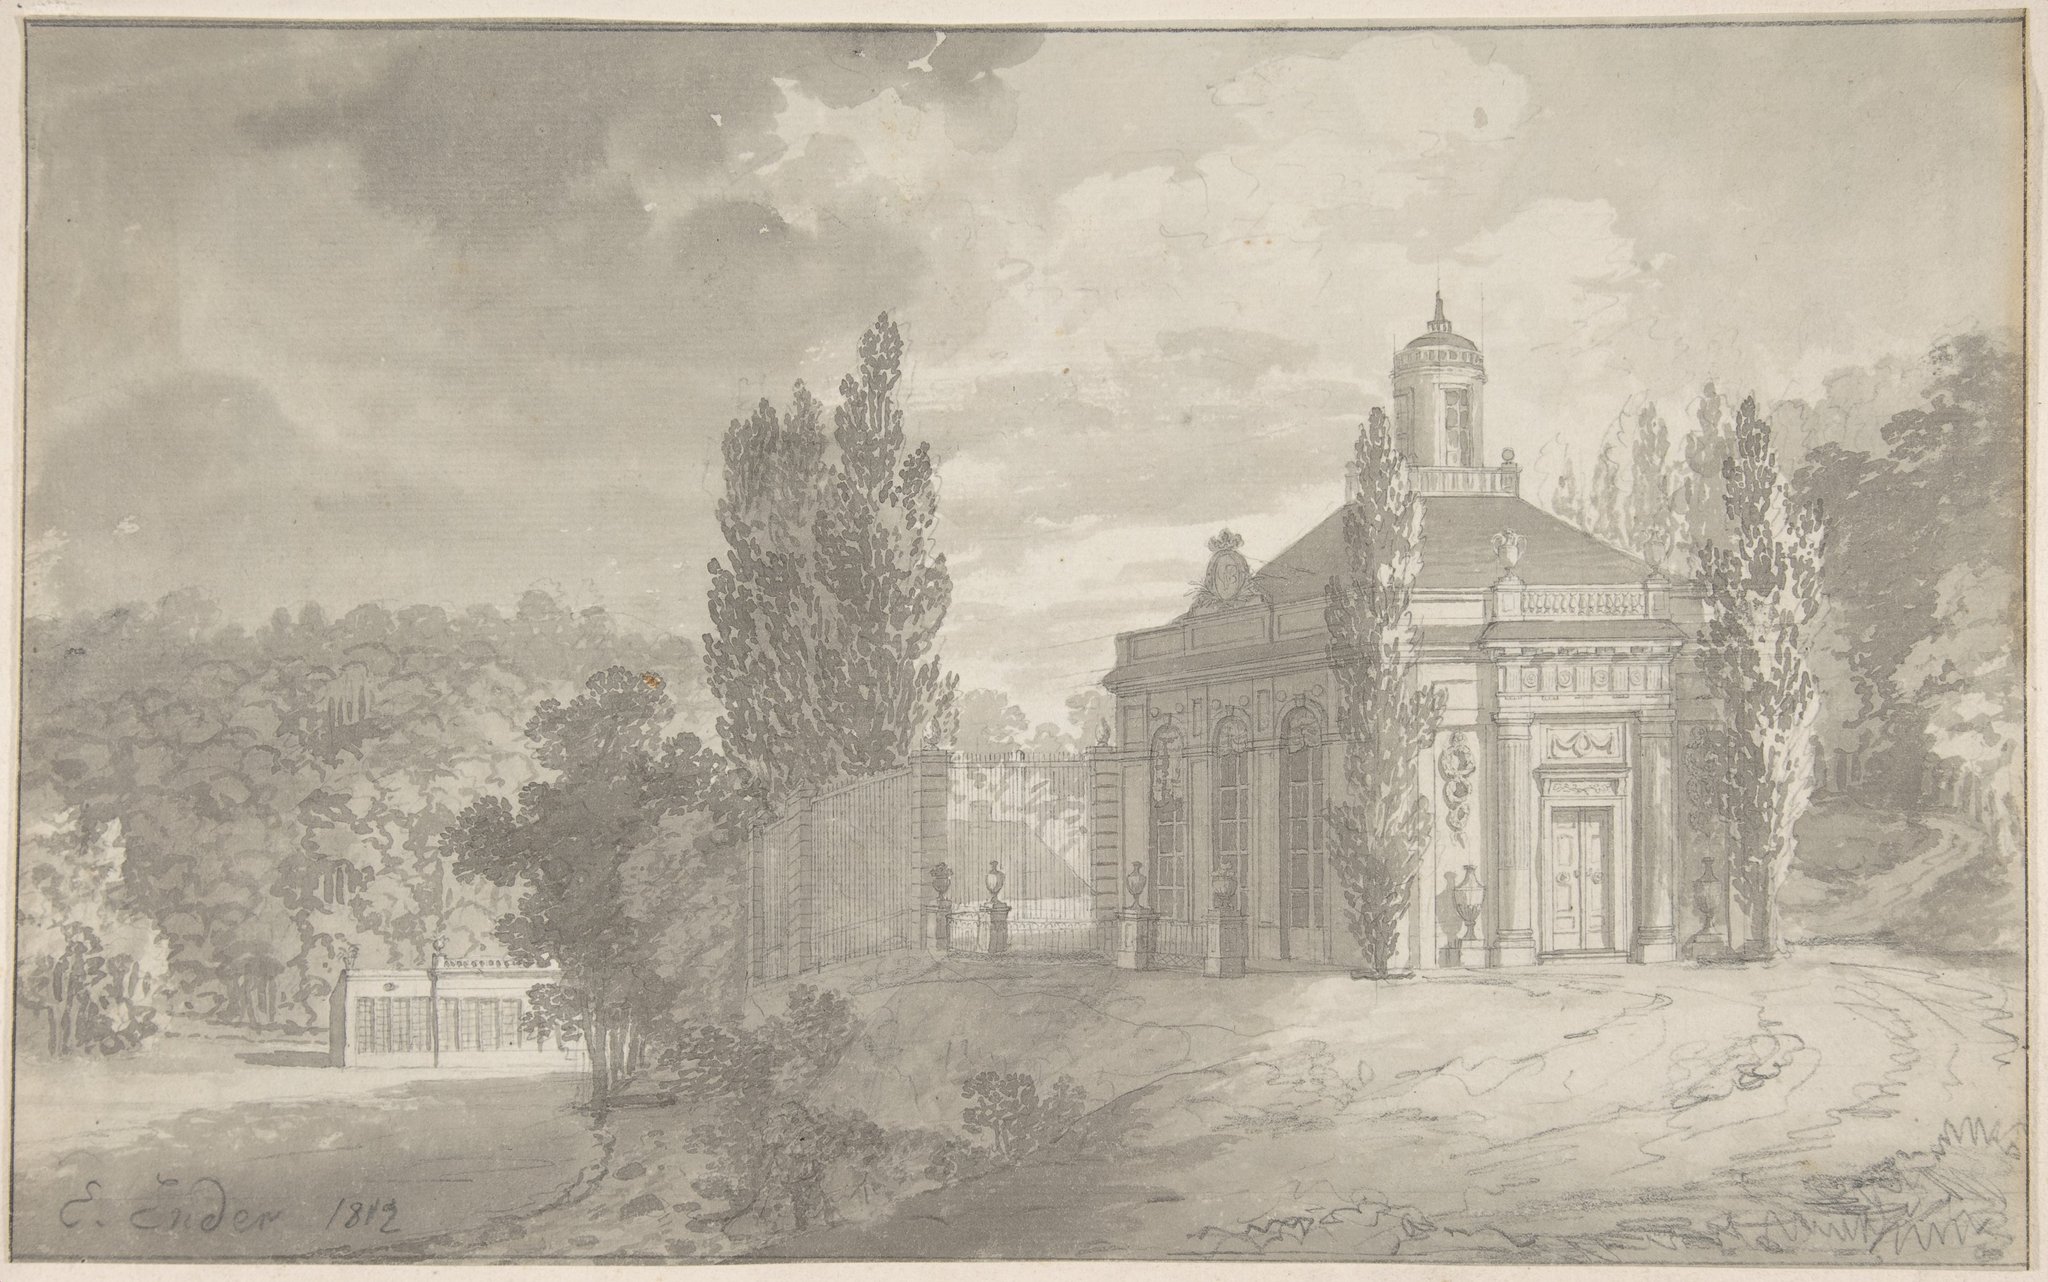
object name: drawing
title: Garden Pavillion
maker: e. ender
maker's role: artist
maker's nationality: austrian (?)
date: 1812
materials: graphite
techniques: brush, wash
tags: gardens,pavilions